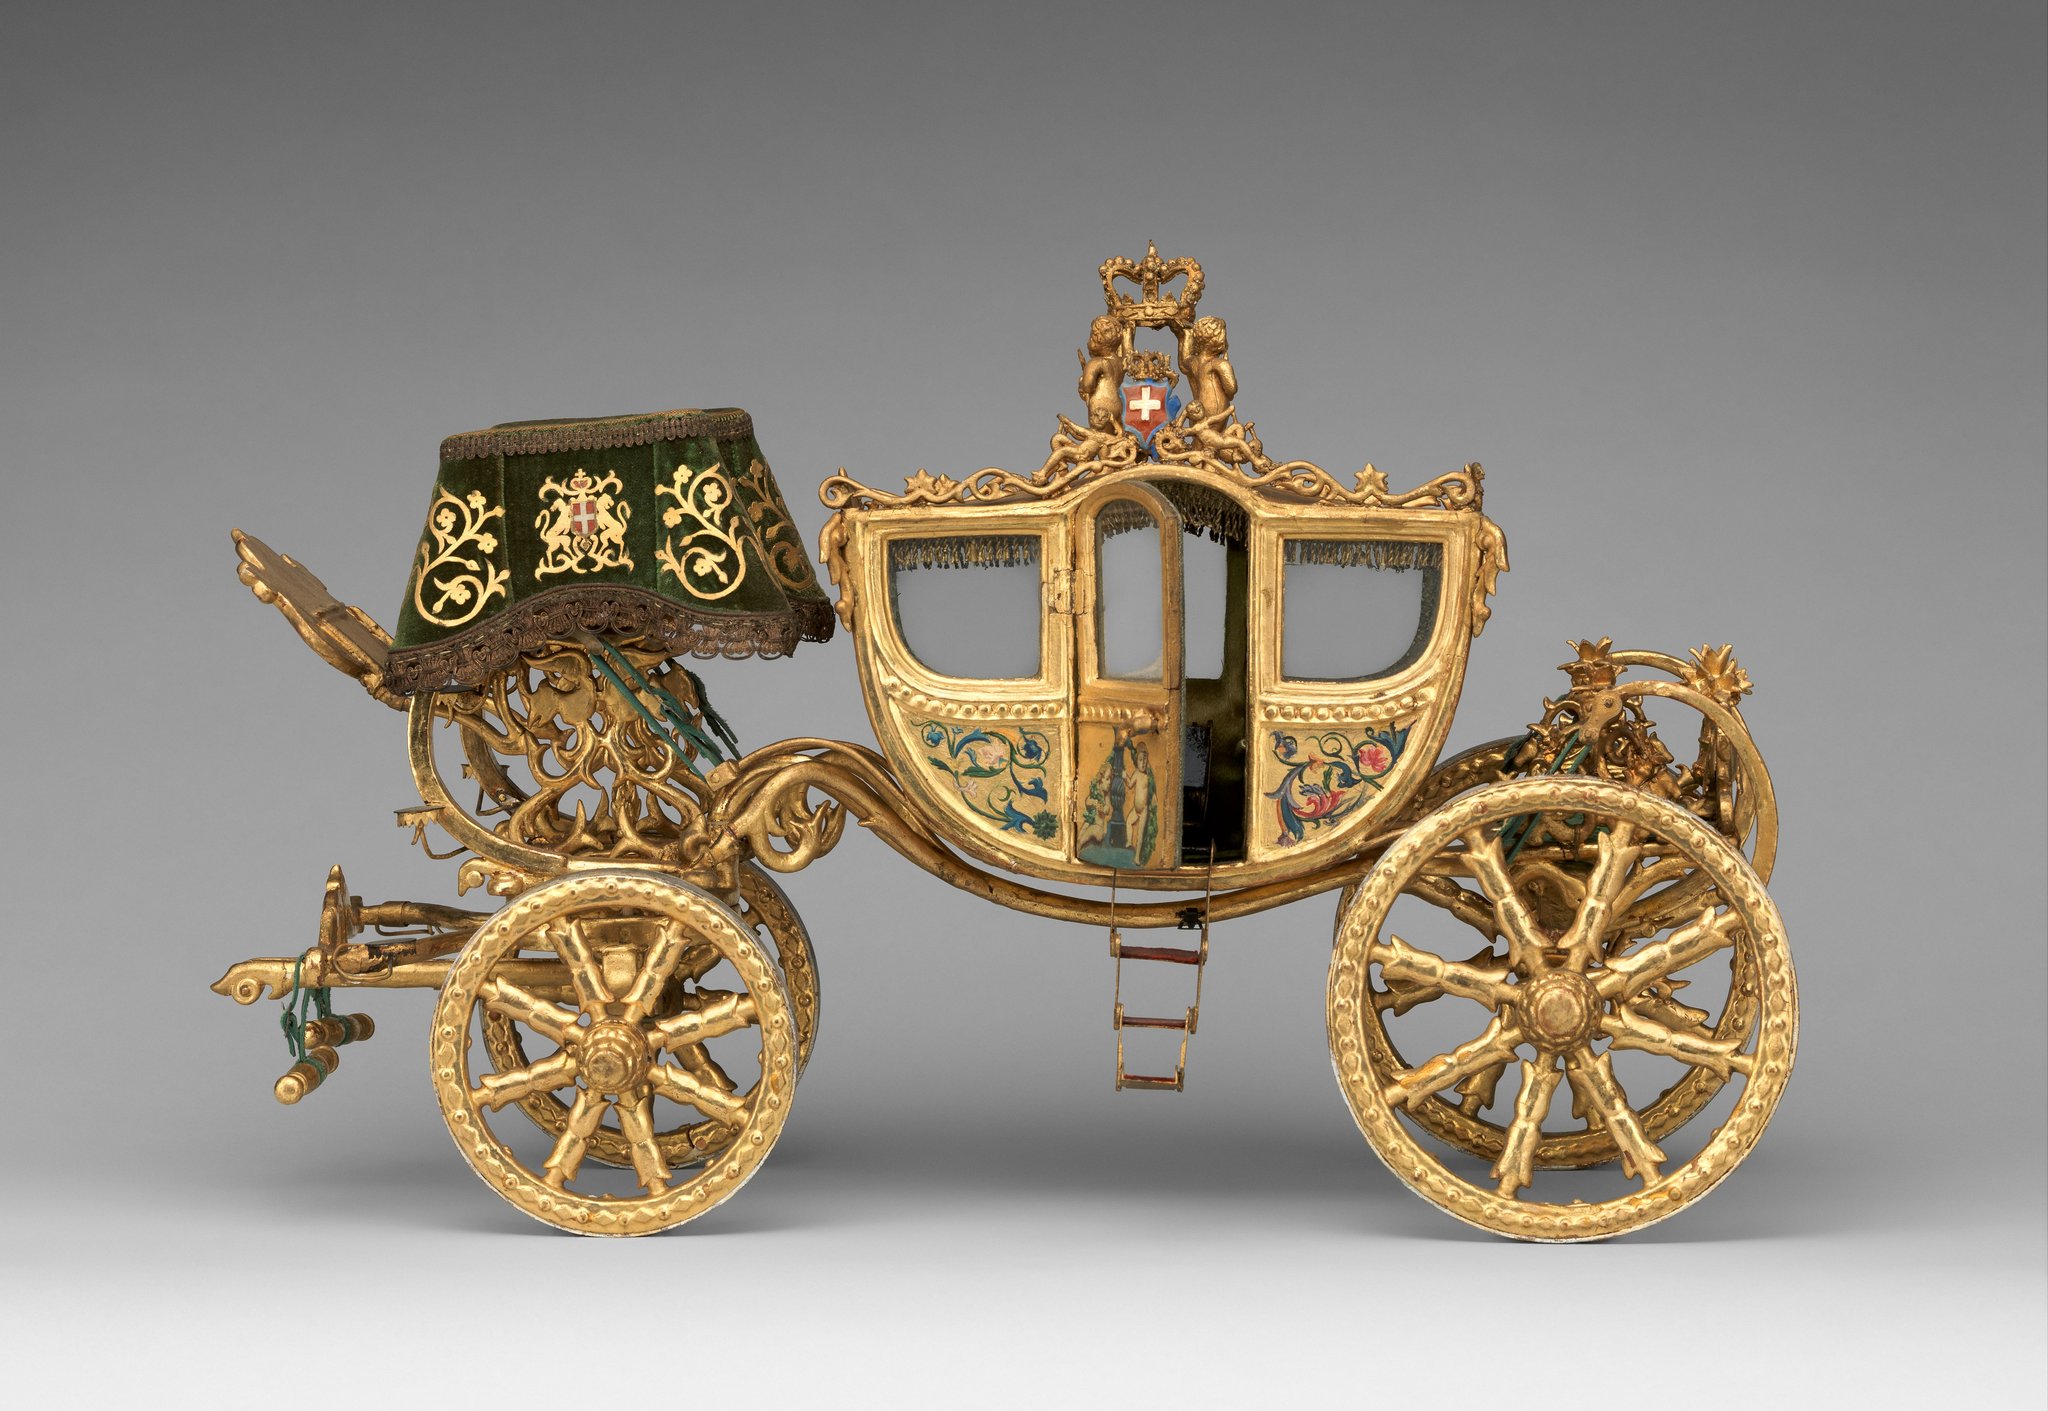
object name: ornament architecture, carriage model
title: Model of a Coach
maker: italian school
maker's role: artist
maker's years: 1800-1899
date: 1801-1900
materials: gilt, glass, tin, velvet, wood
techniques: painting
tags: carriages